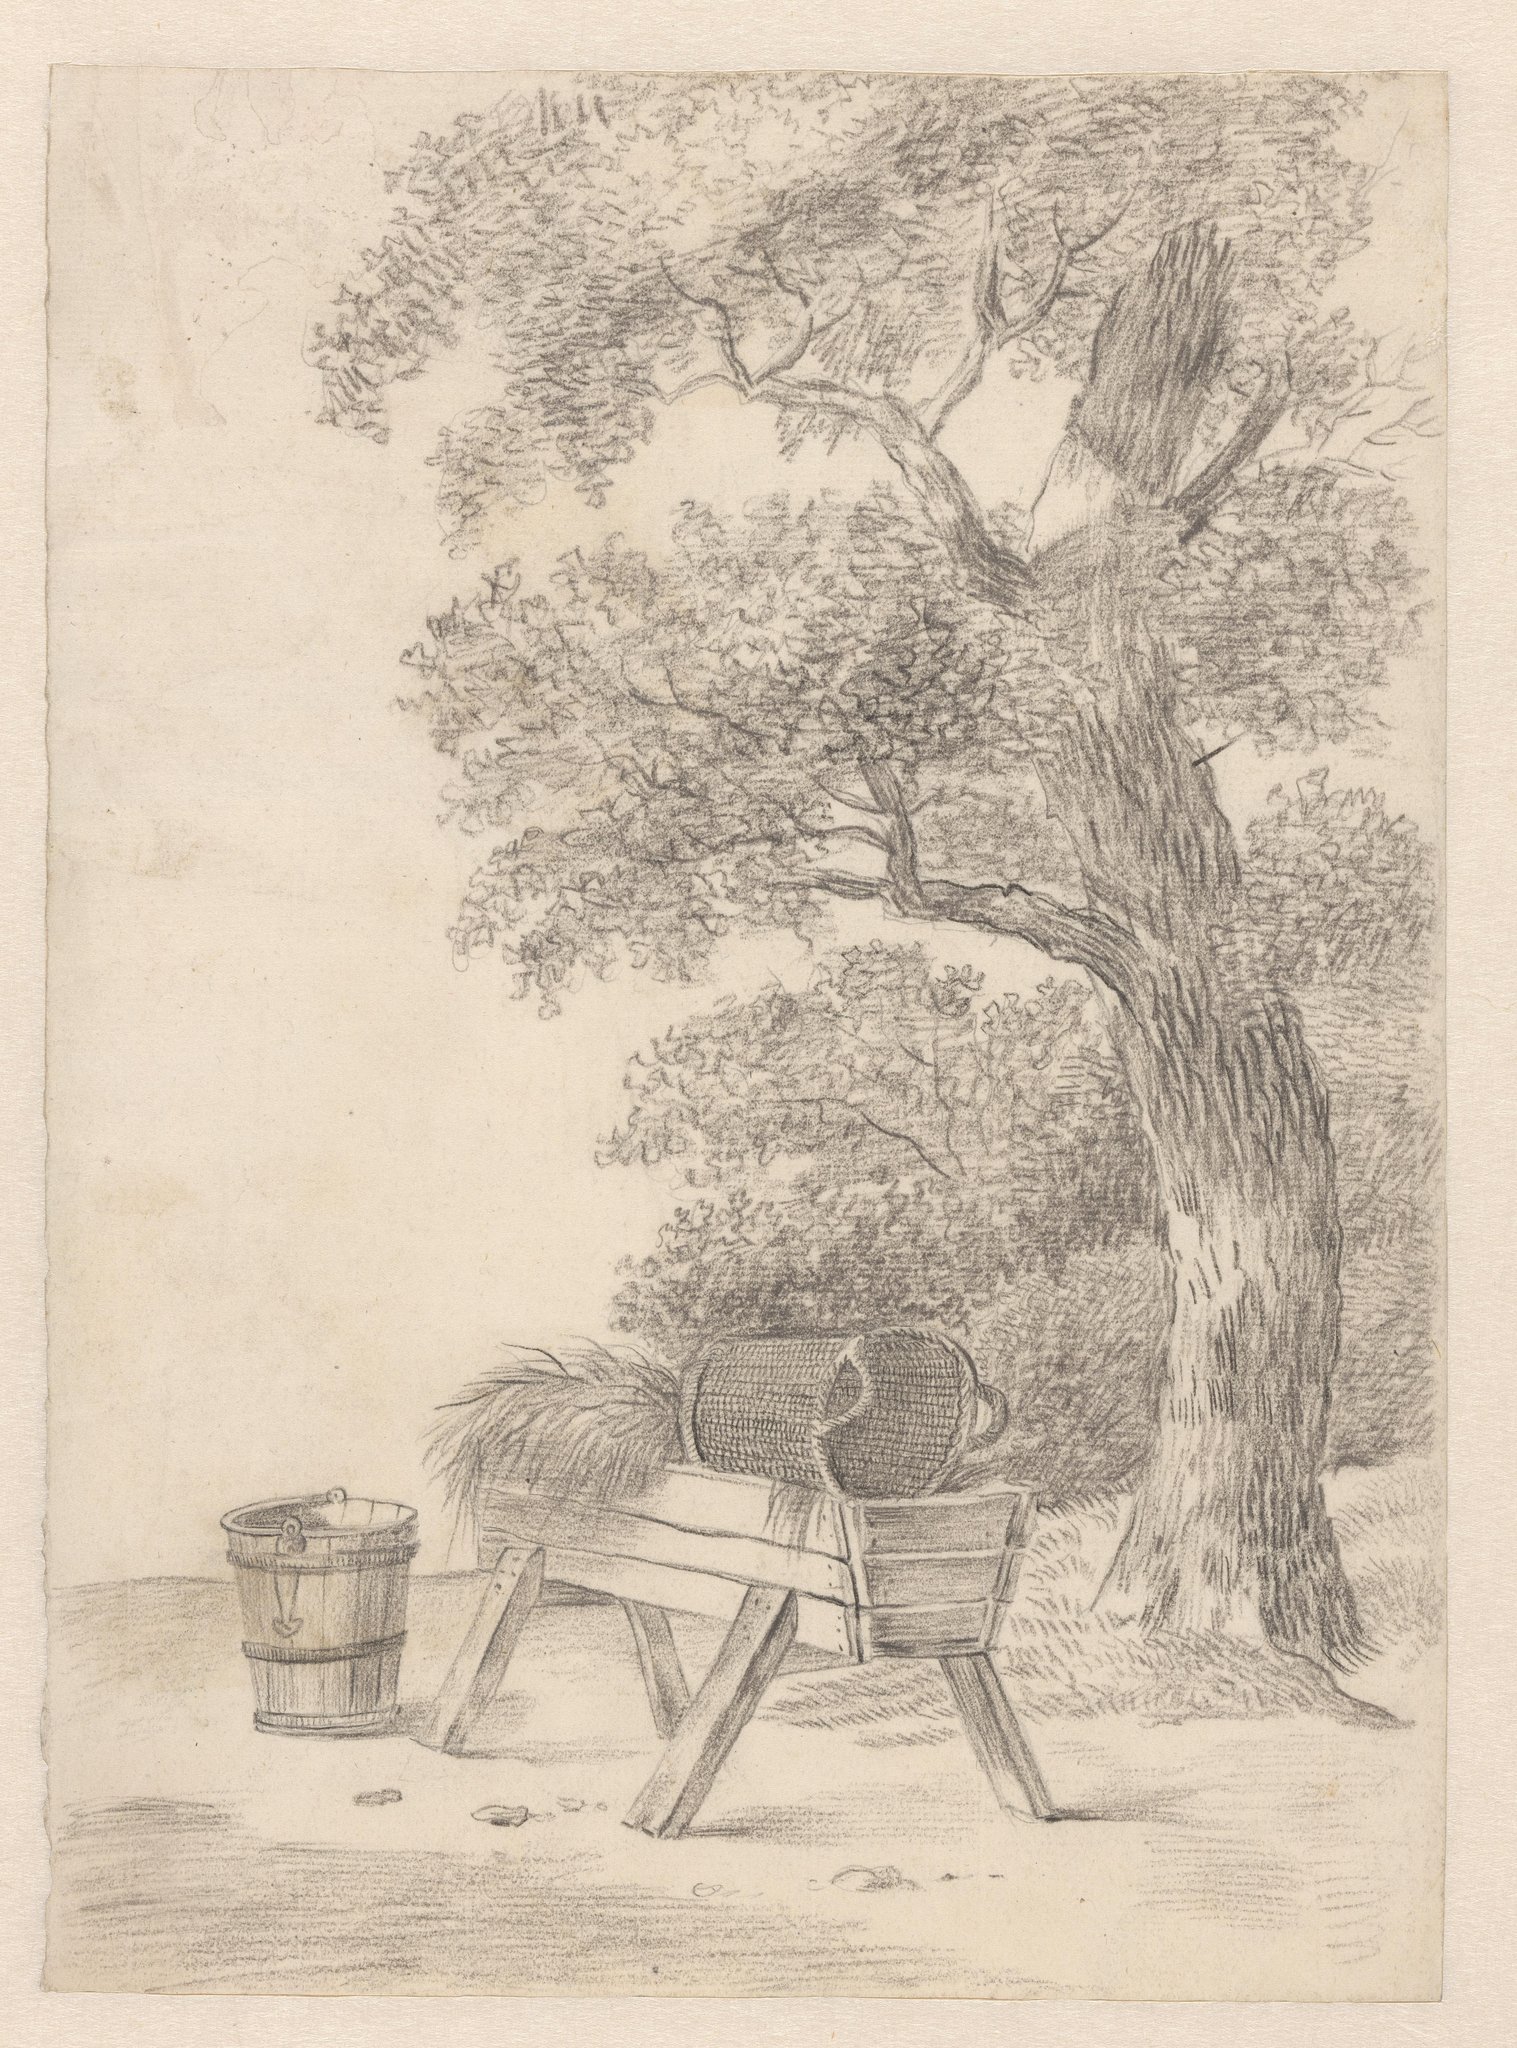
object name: drawing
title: Ruif met hooi onder een boom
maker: joannes carolus alberdingk thijm (jan)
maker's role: pater, schrijver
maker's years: 1847-1926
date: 1853-1860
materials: chalk, paper, pencil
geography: netherlands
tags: trees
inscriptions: inscription: ‘A.Th.’